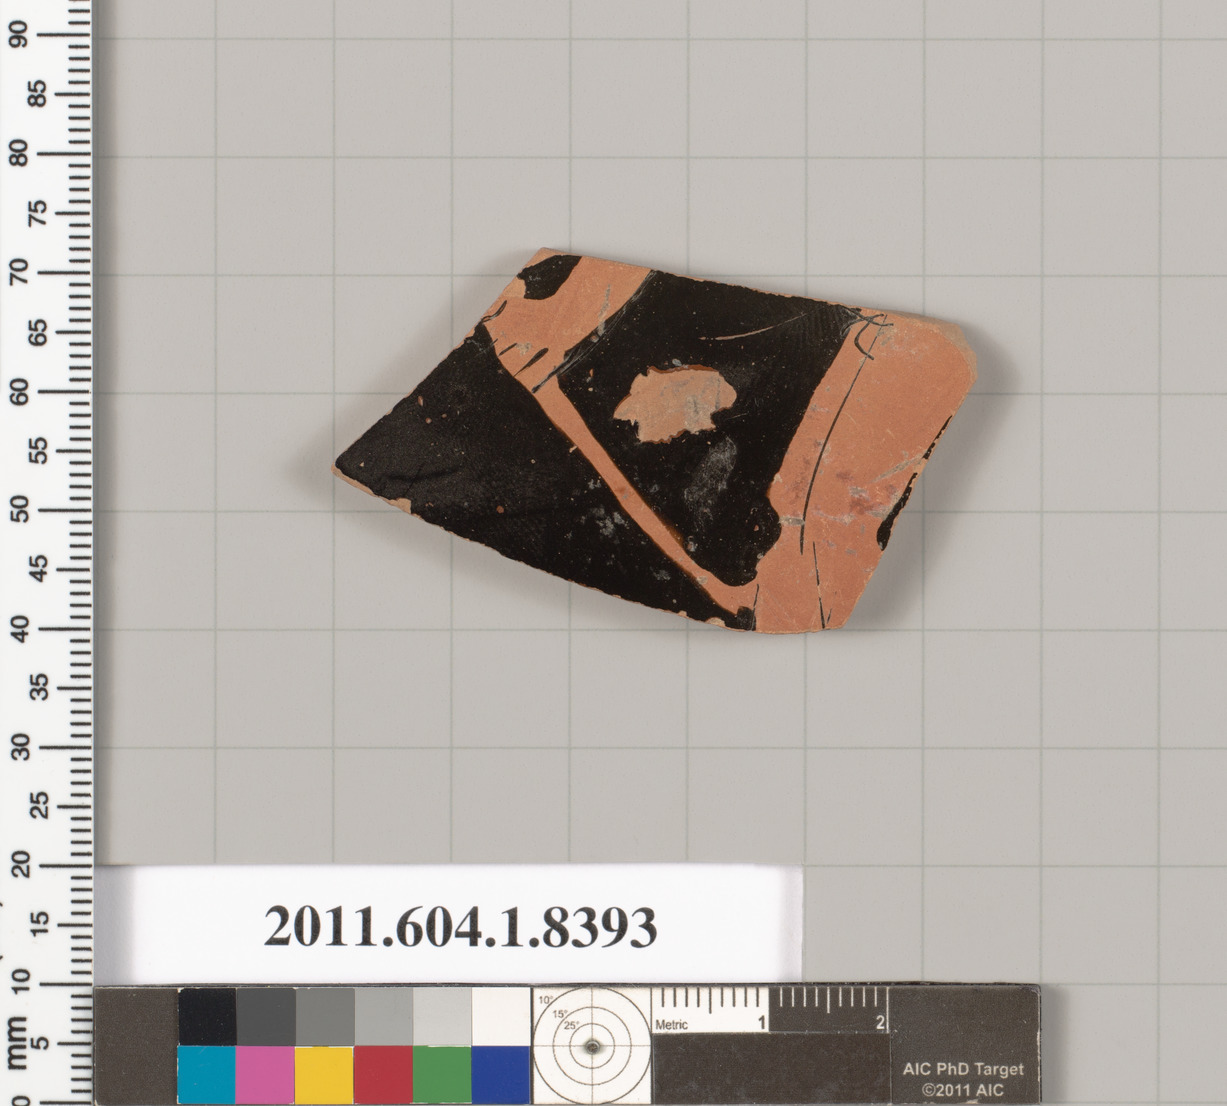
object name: kylix fragment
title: Terracotta fragment of a kylix (drinking cup)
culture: greek, attic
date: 367-335 BCE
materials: terracotta